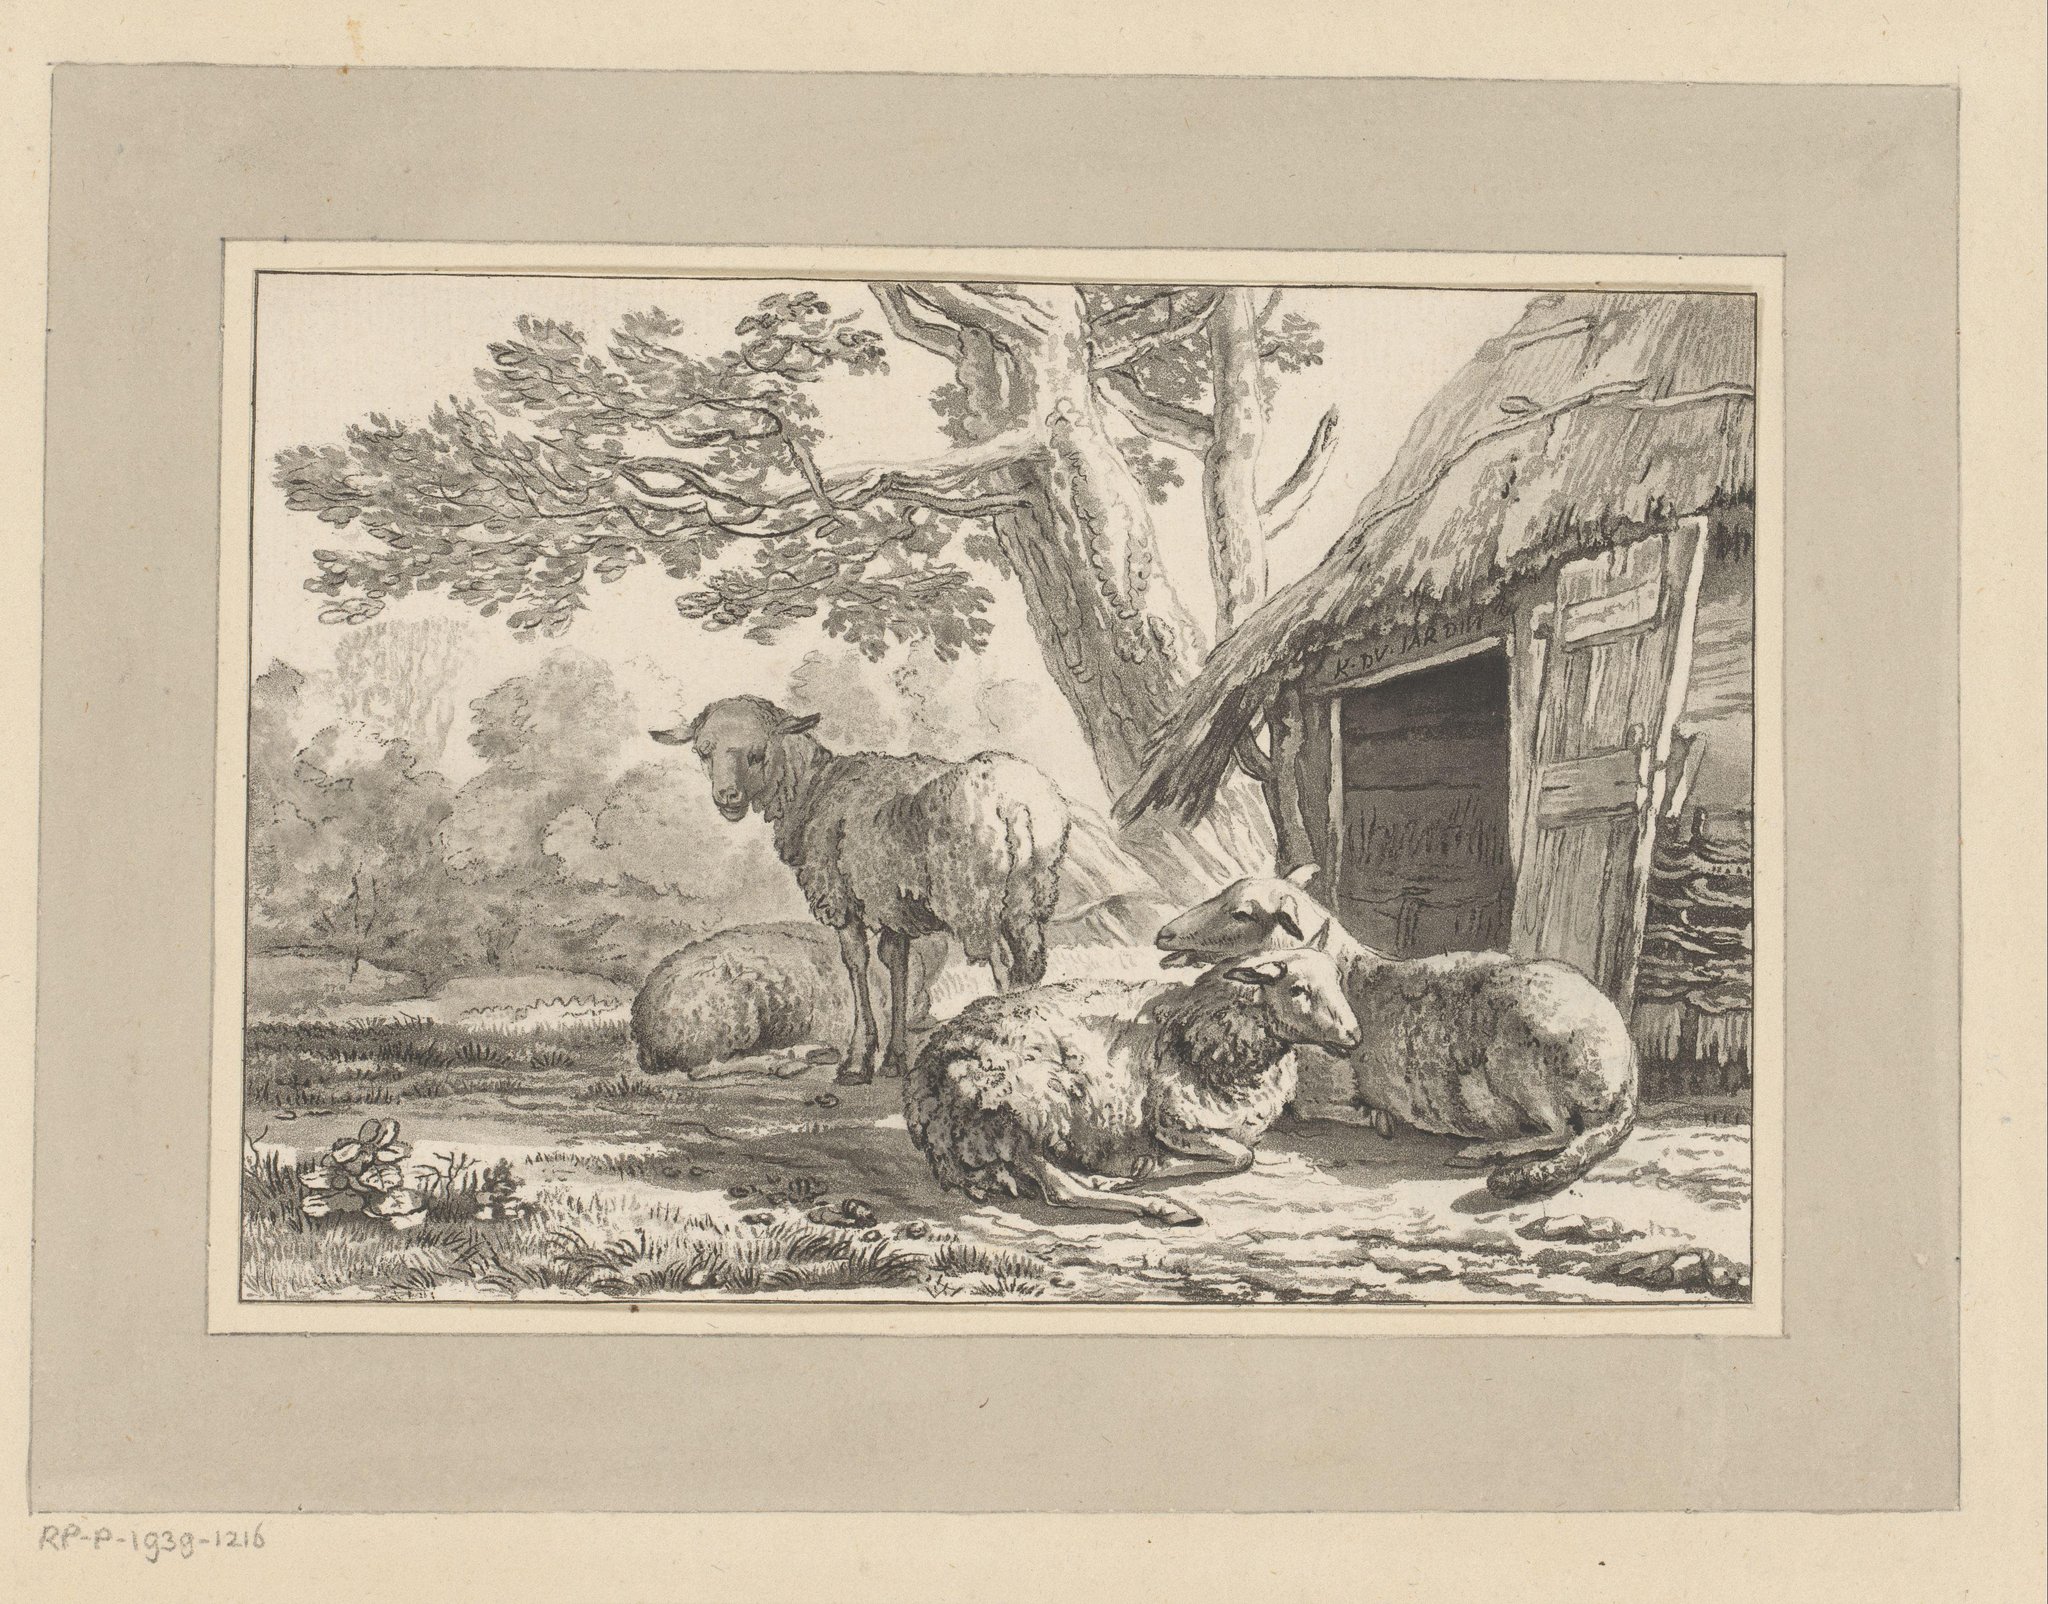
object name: print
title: Schaapskooi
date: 1781-1787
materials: paper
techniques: etching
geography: amsterdam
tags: sheep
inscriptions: collector's mark: ‘RIJKS / MUSM’, collector's mark: Lugt 2725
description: Vier schapen bij de geopende schaapskooi. De prent ligt los in een album, zie blad 44.